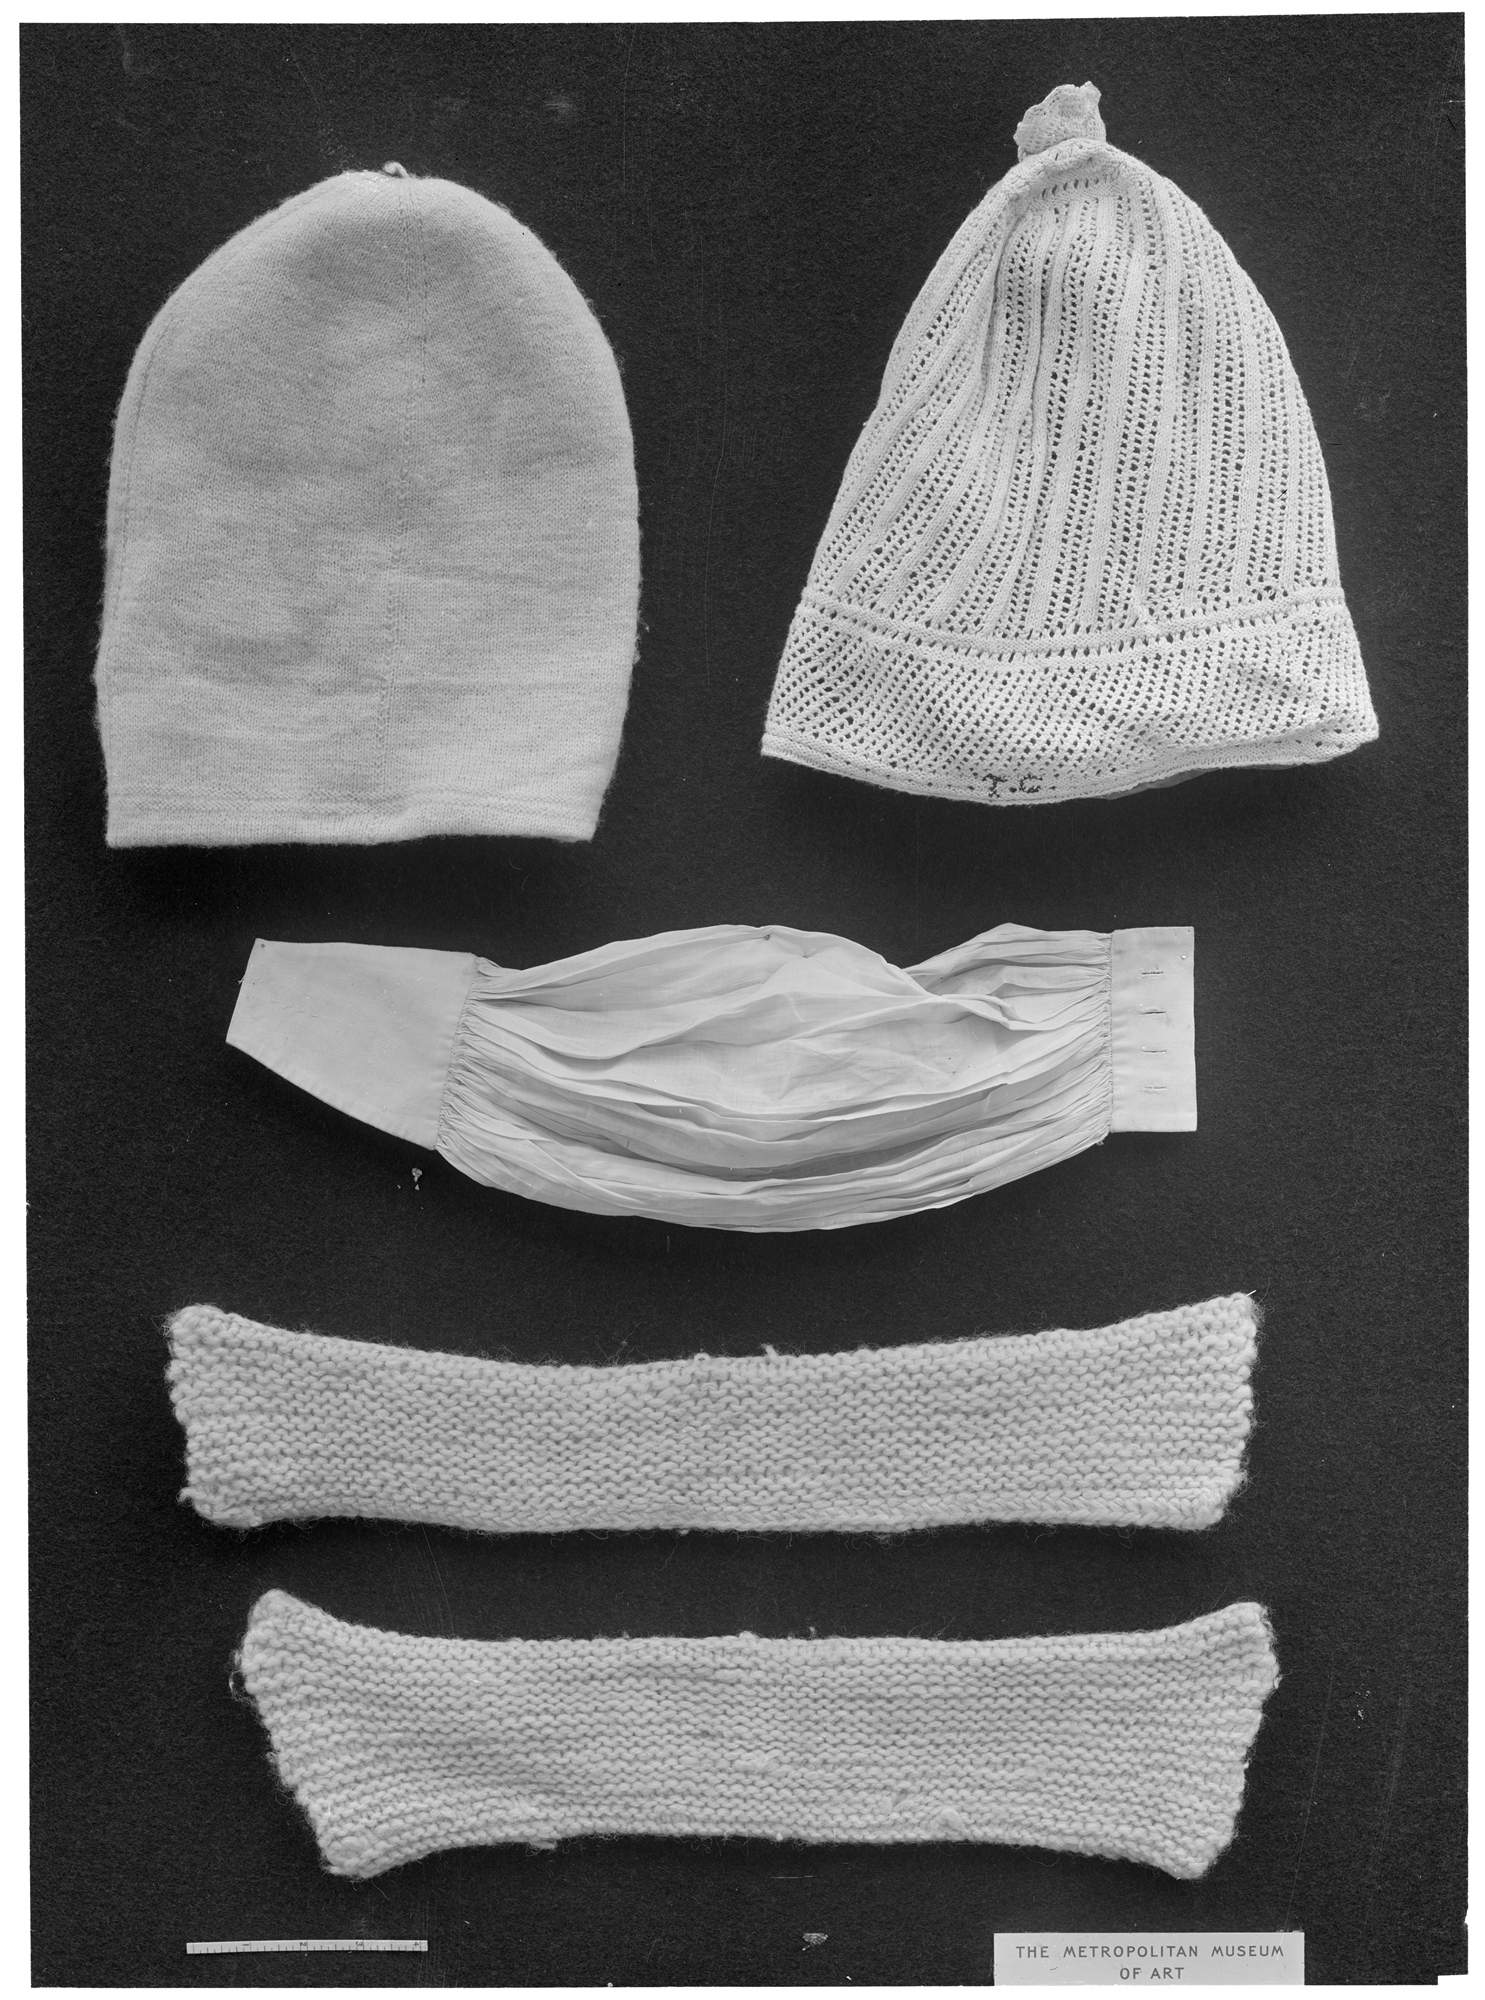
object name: night cap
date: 1801-1833